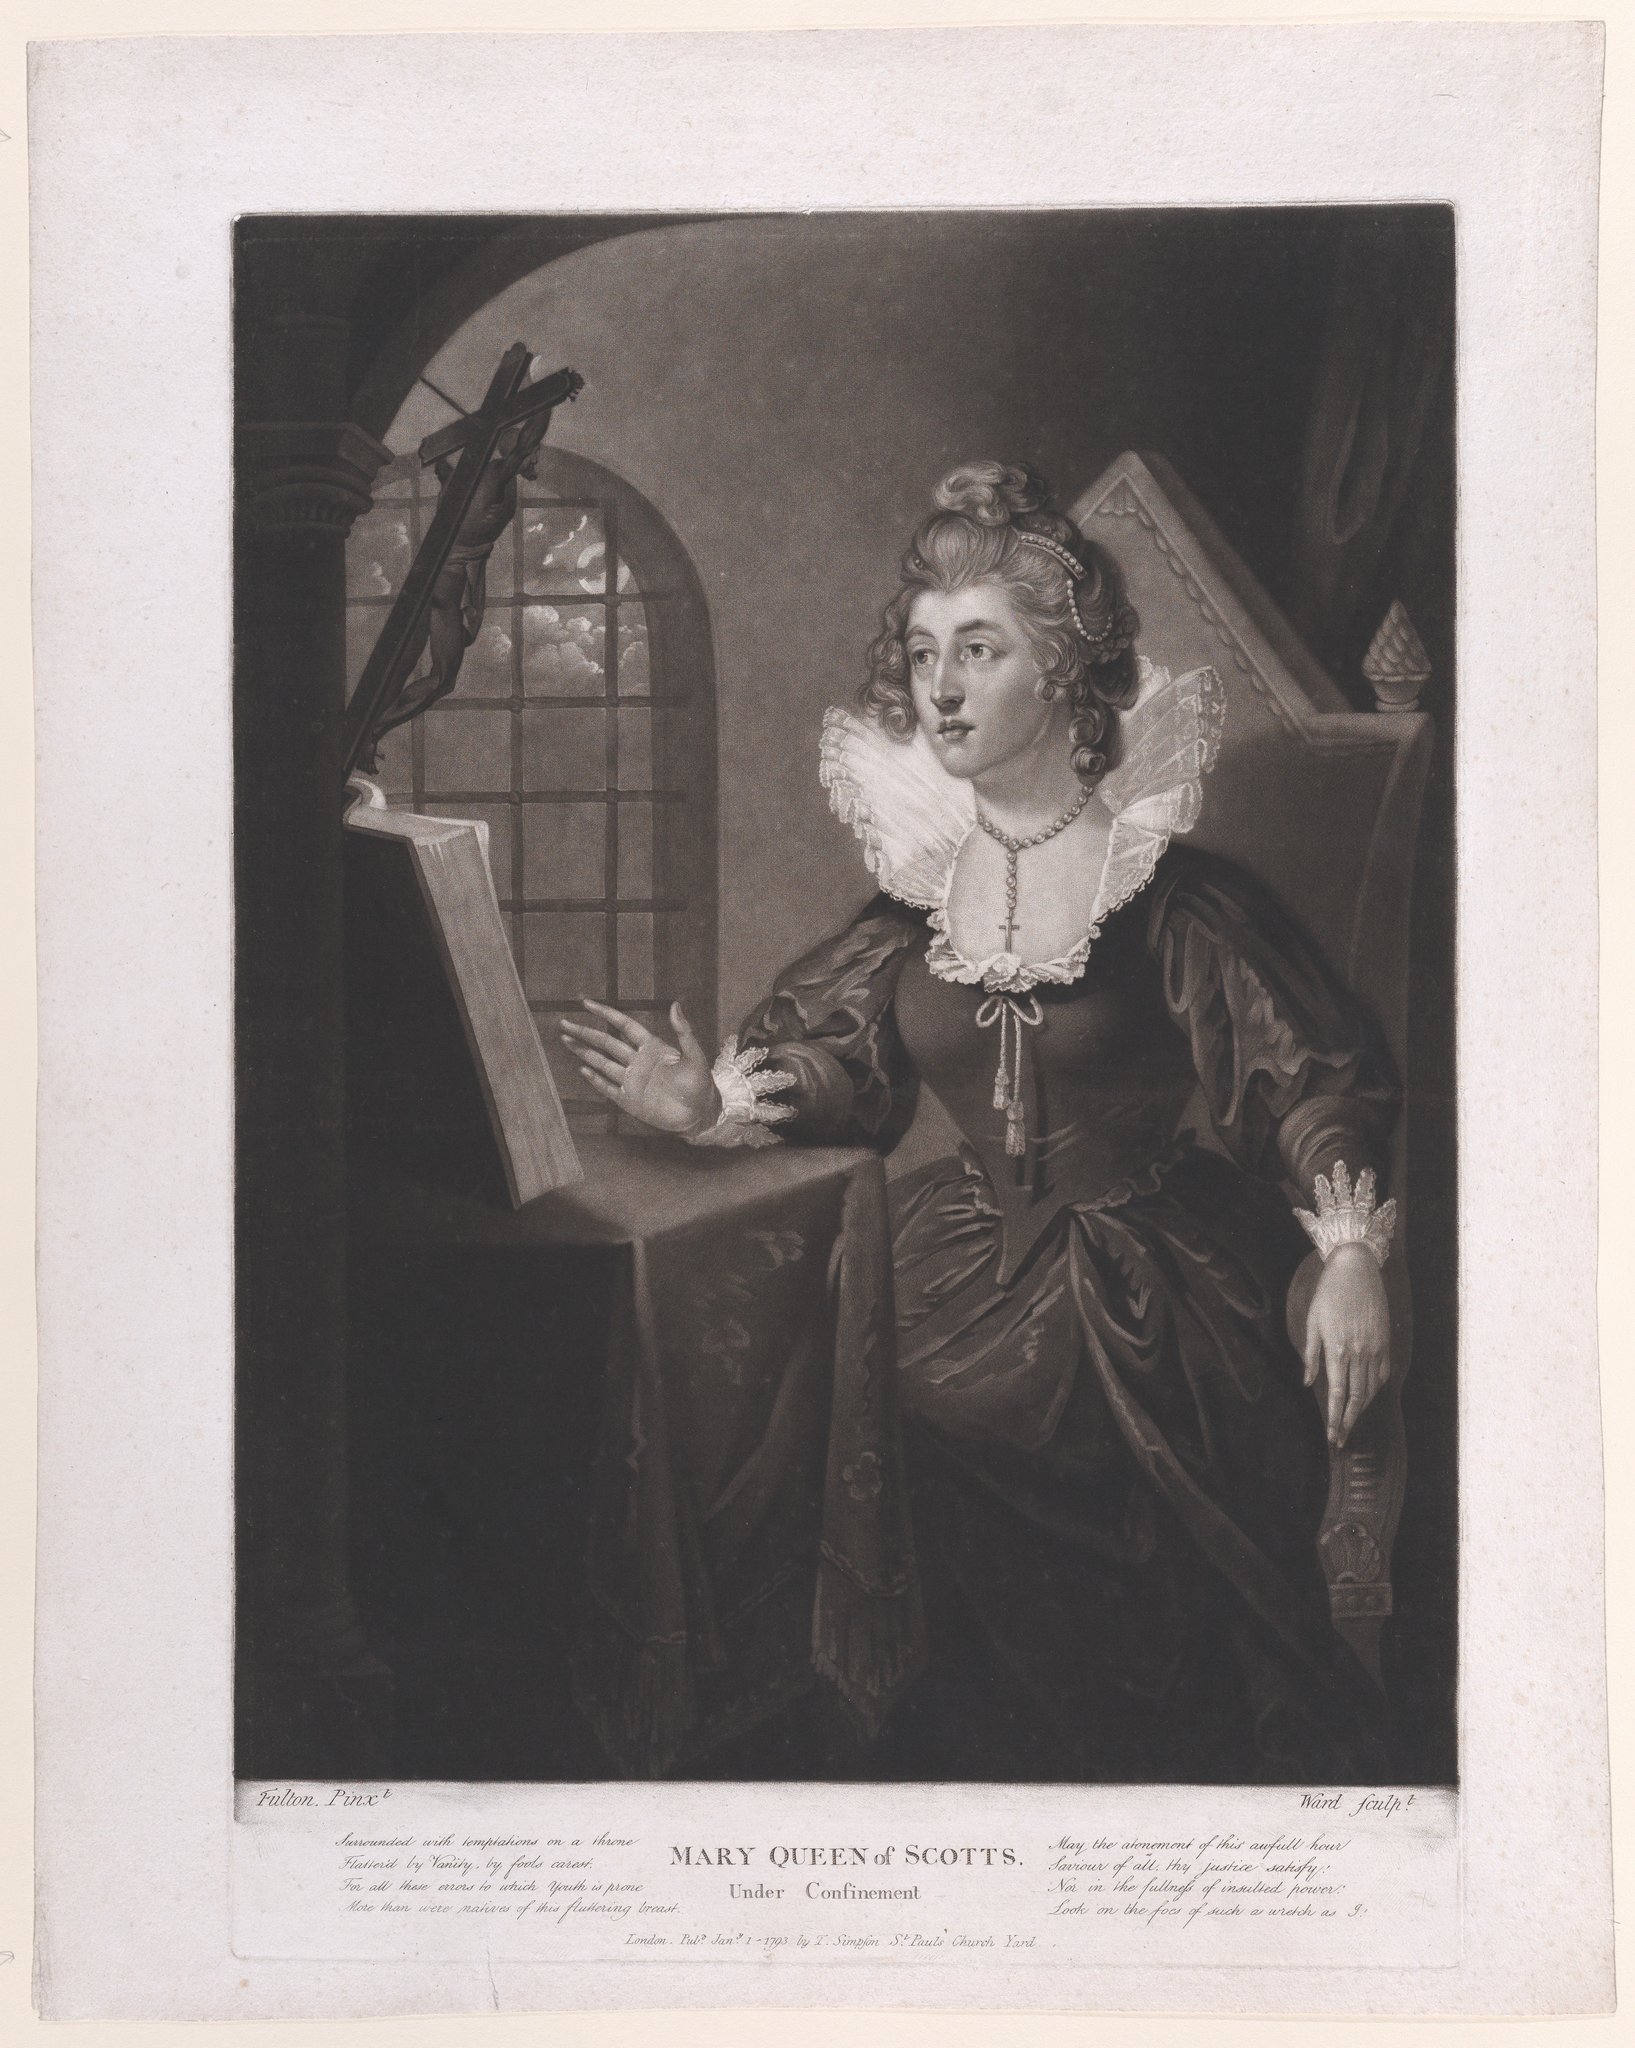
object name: print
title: Mary, Queen of Scots, Under Confinement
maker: william ward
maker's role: engraver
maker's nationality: british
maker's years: 1766-1826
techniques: mezzotint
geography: england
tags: queens,women,mary queen of scots